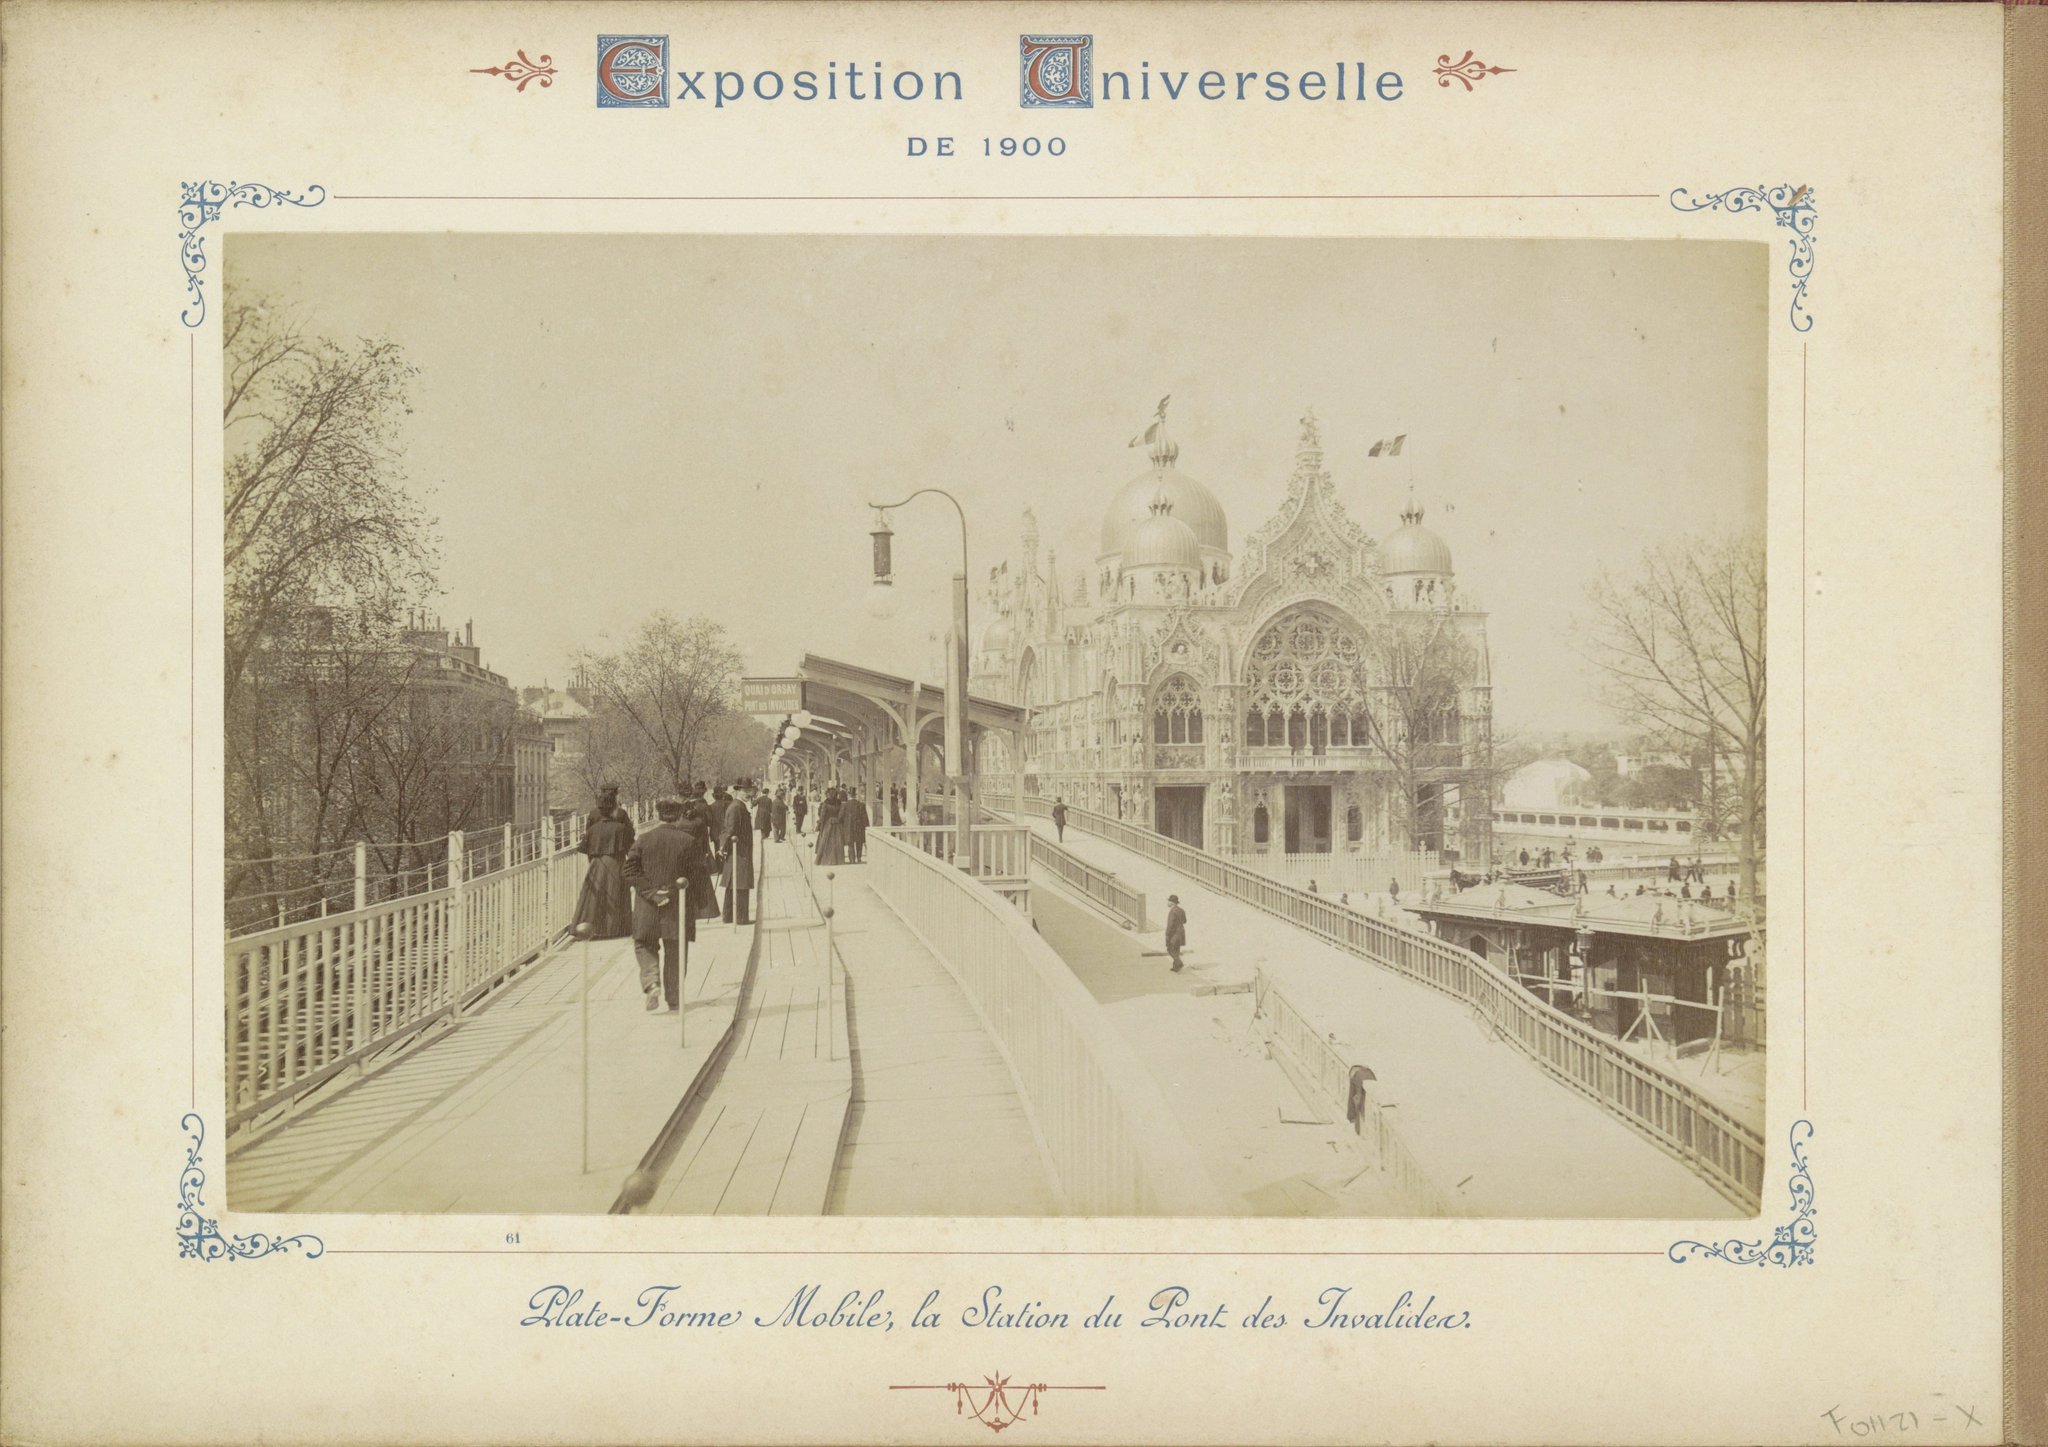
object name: photograph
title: Bewegende loopbanden bij het Station du Pont des Invalides in Parijs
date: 1900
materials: cardboard, paper, photographic support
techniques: albumen print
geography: paris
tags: horizontal transport (industrial process), world fair, world exhibition, station; shelter (railway, tramway), paris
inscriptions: number: ‘61’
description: Onderdeel van Fotoalbum met opnames van de Wereldtentoonstelling van 1900 in Parijs.